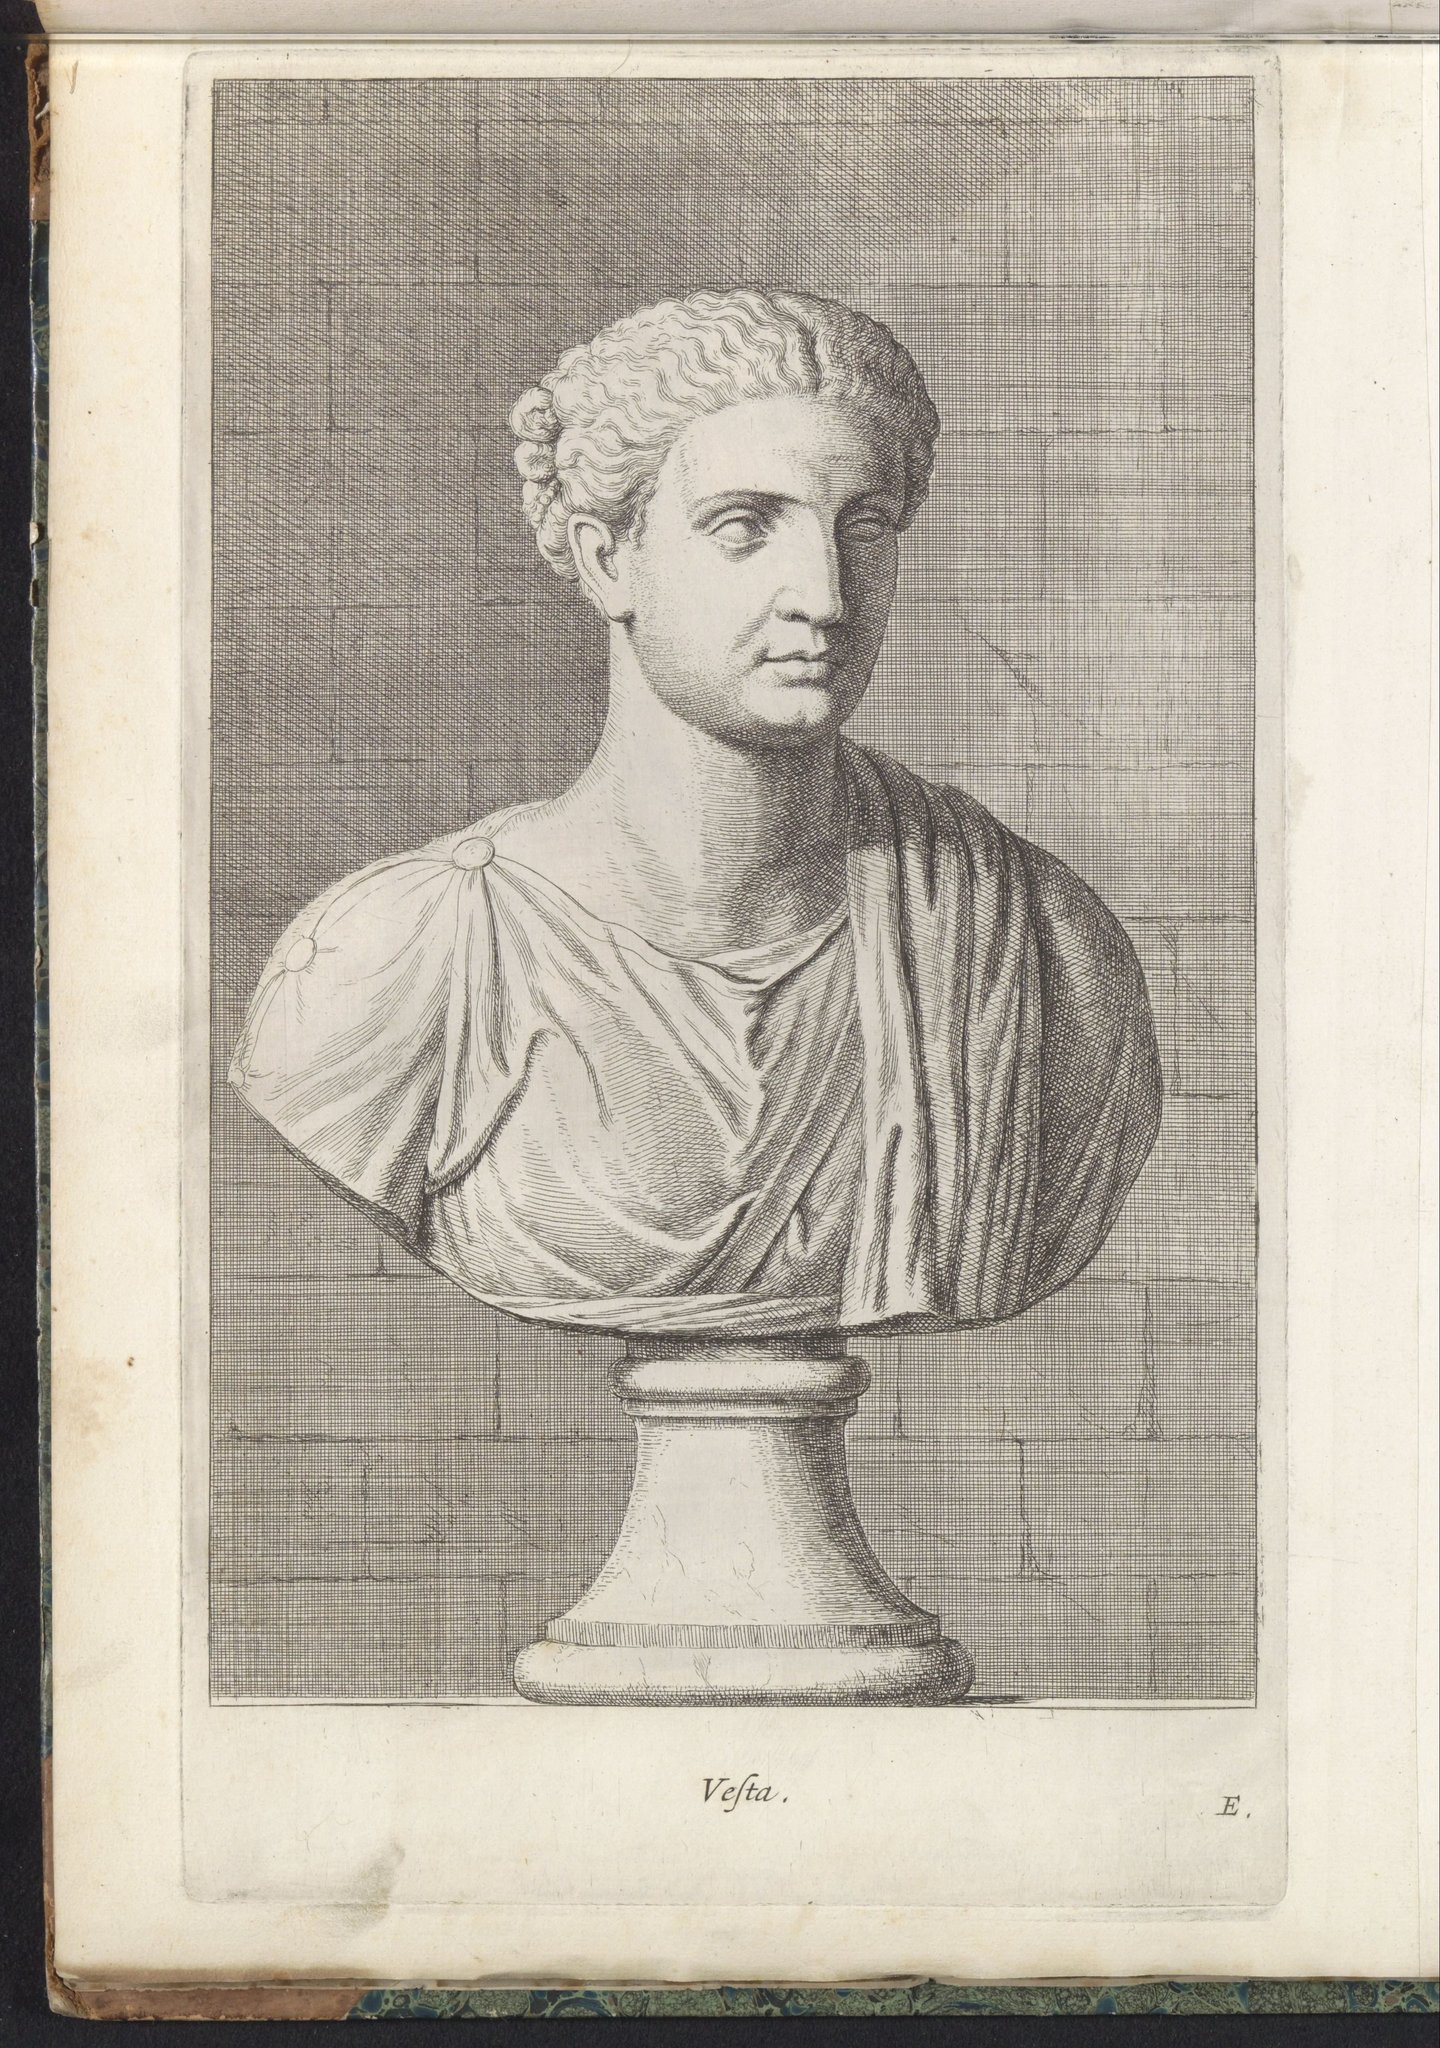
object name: album leaf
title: Buste van de godin Vesta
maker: hubert quellinus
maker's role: print maker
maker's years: 1619-1687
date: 1646-1670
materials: paper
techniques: engraving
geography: antwerp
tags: (story of) vesta (hestia), piece of sculpture, reproduction of a piece of sculpture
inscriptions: number: ‘36’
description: Klassieke buste van een vrouw in tunica. Rechtsonder: E. De prent maakt deel uit van een album met een serie prenten naar de sculpturen in de verzameling van Gerard Reynst.